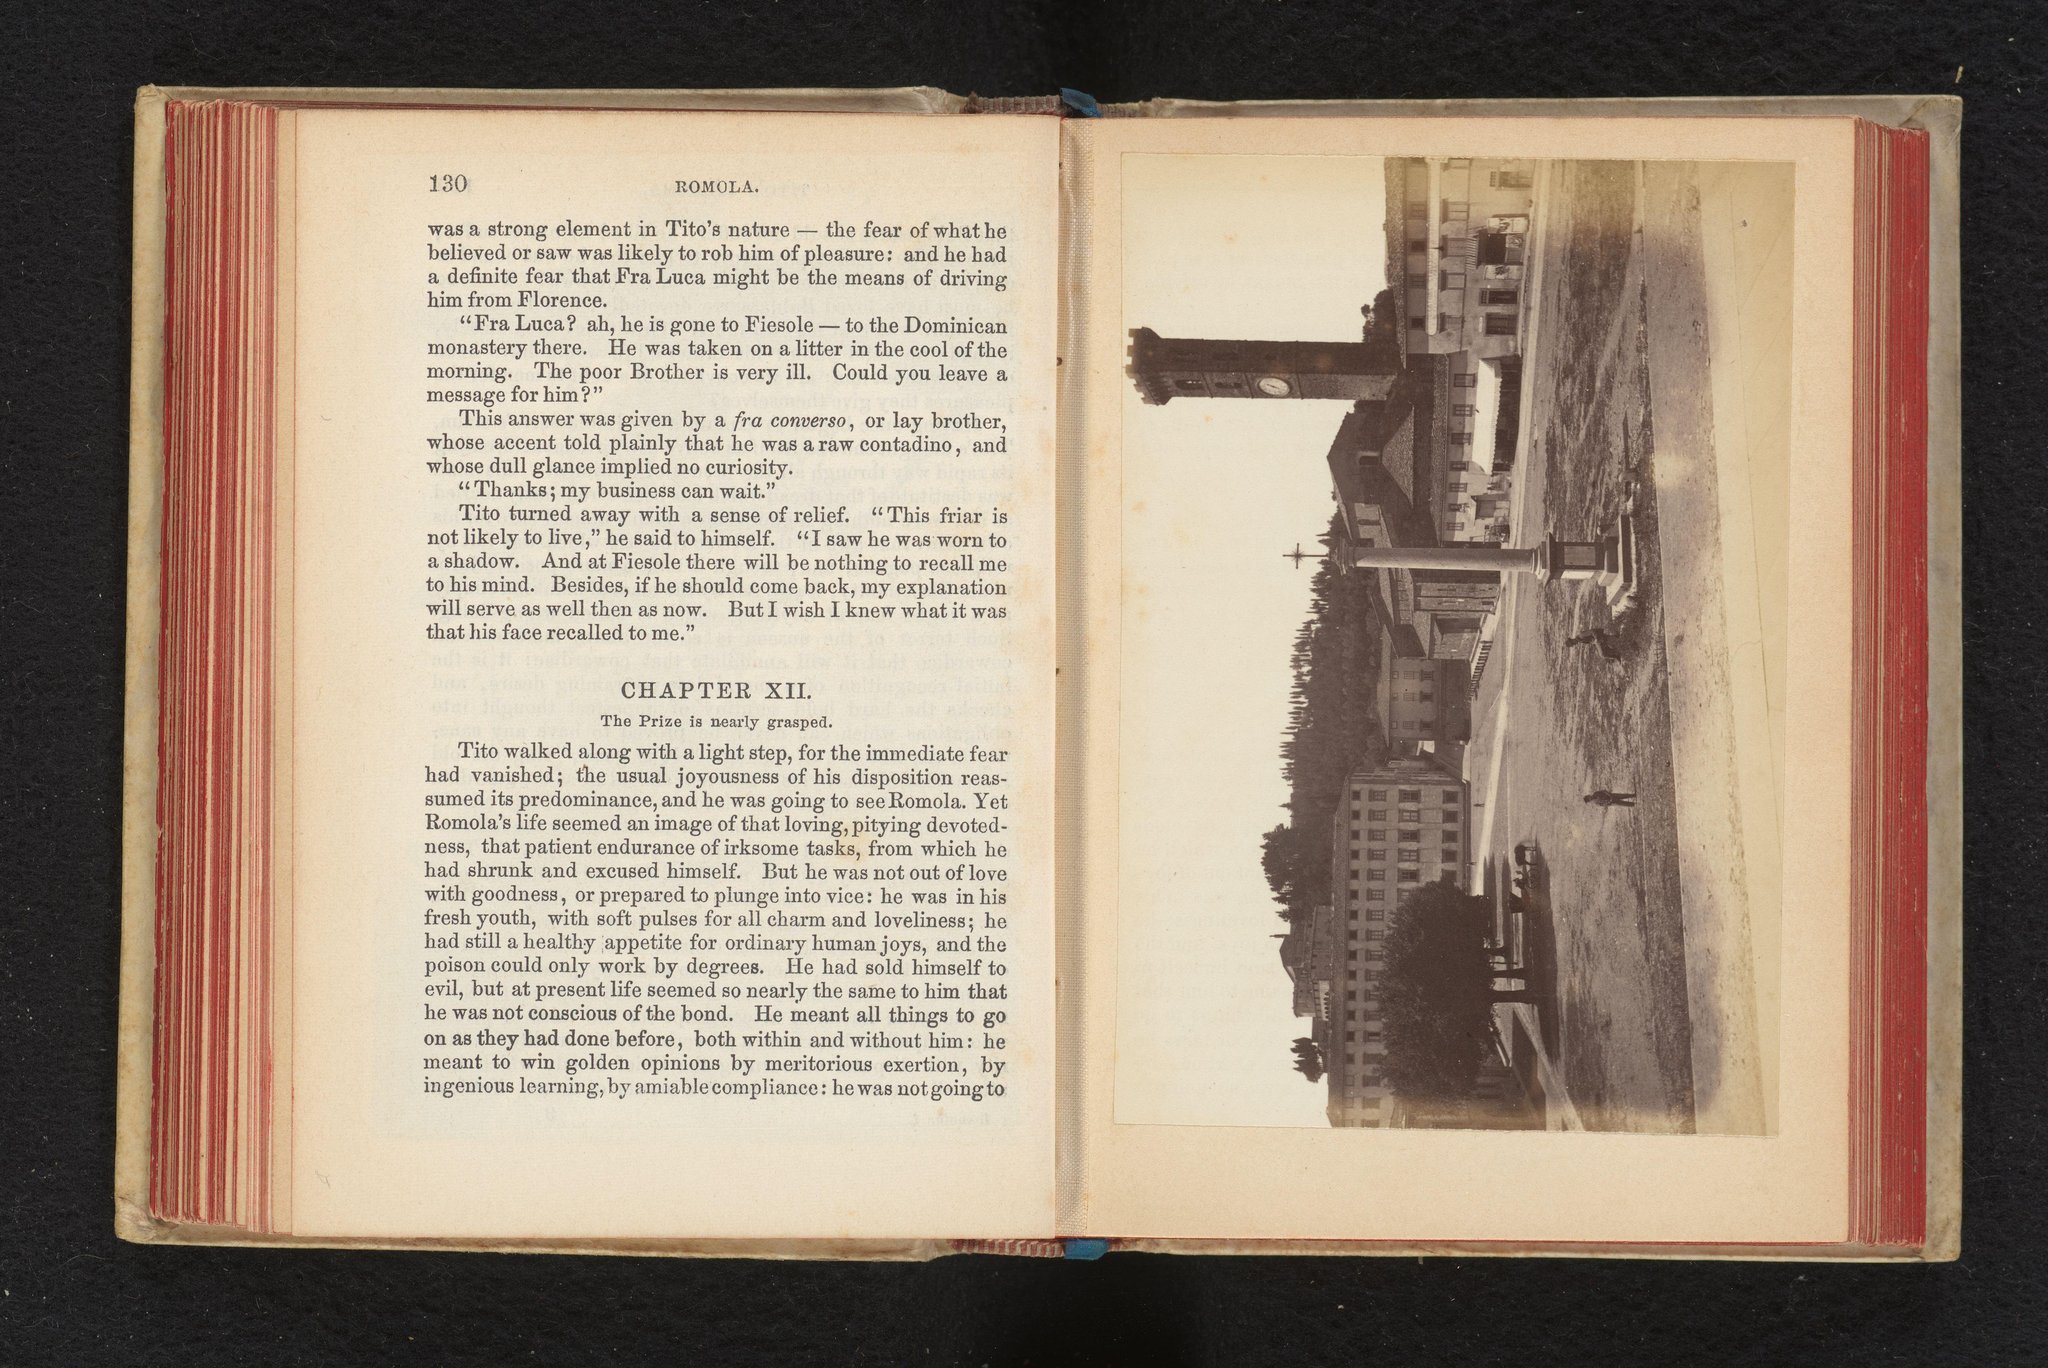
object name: page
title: Gezicht op het centrale plein van Fiesole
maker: giacomo brogi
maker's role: fotograaf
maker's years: 1822-1881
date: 1858-1863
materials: paper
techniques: albumen print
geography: fiesole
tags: village square, place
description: Foto op ongenummerde pagina tegenover pagina 130.